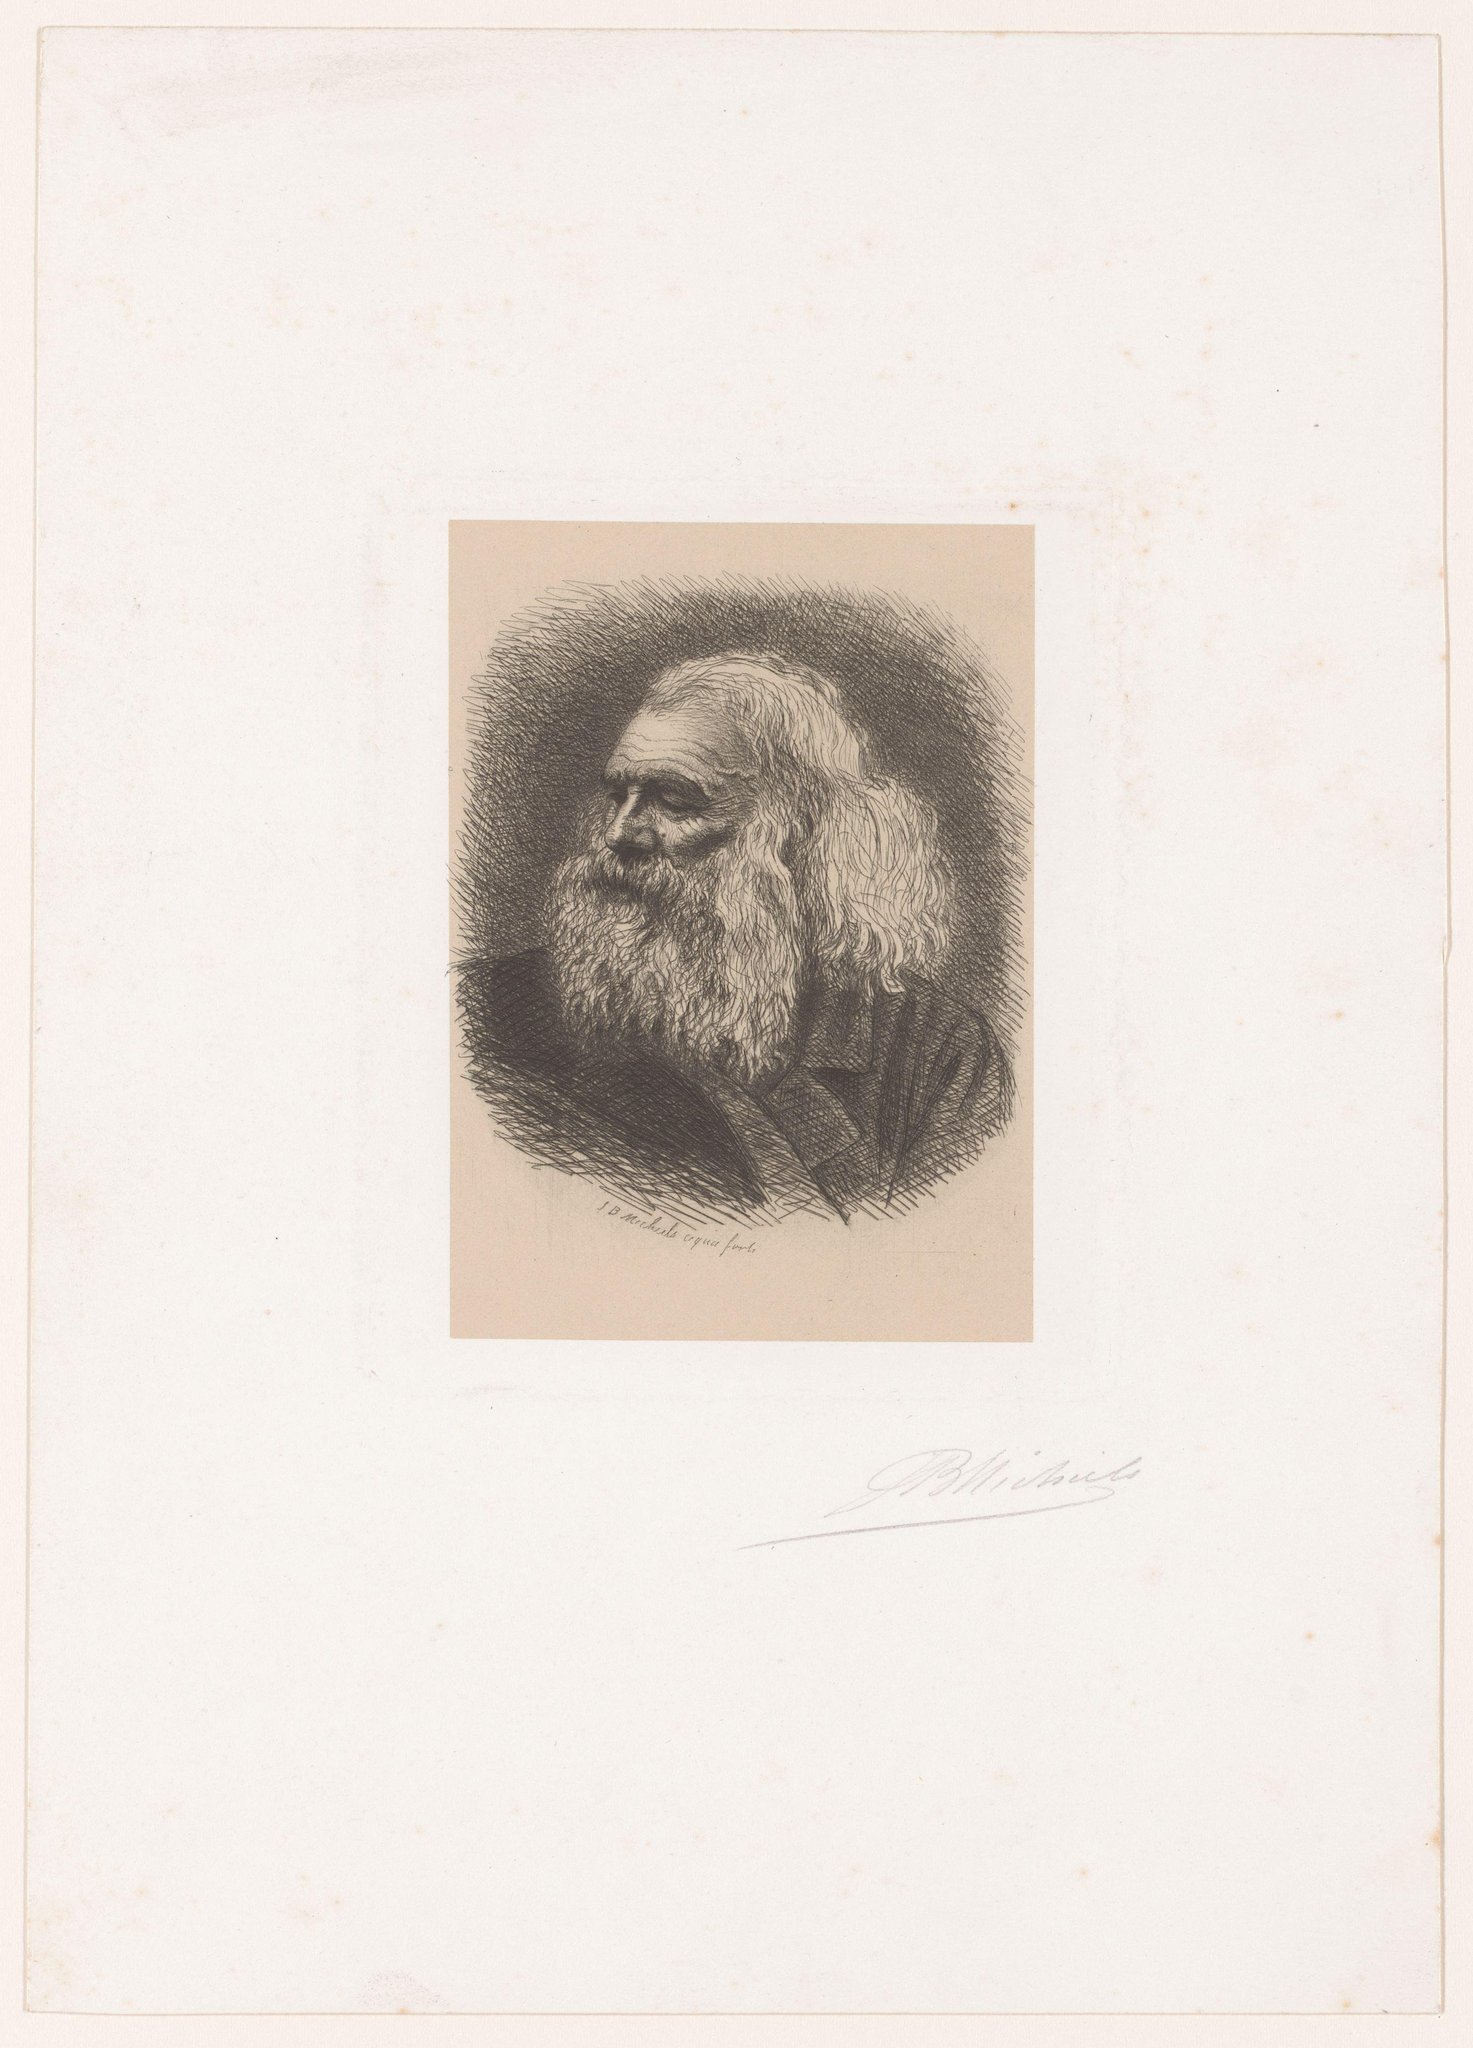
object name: print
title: Hoofd van een oude man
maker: jean baptiste pierre michiels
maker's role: print maker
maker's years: 1821-1890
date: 1831-1890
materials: paper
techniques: etching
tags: old man, beard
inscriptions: collector's mark: Lugt 2228